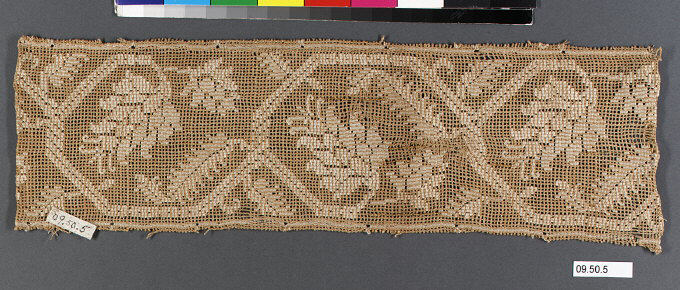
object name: strip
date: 1501-1600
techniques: embroidery